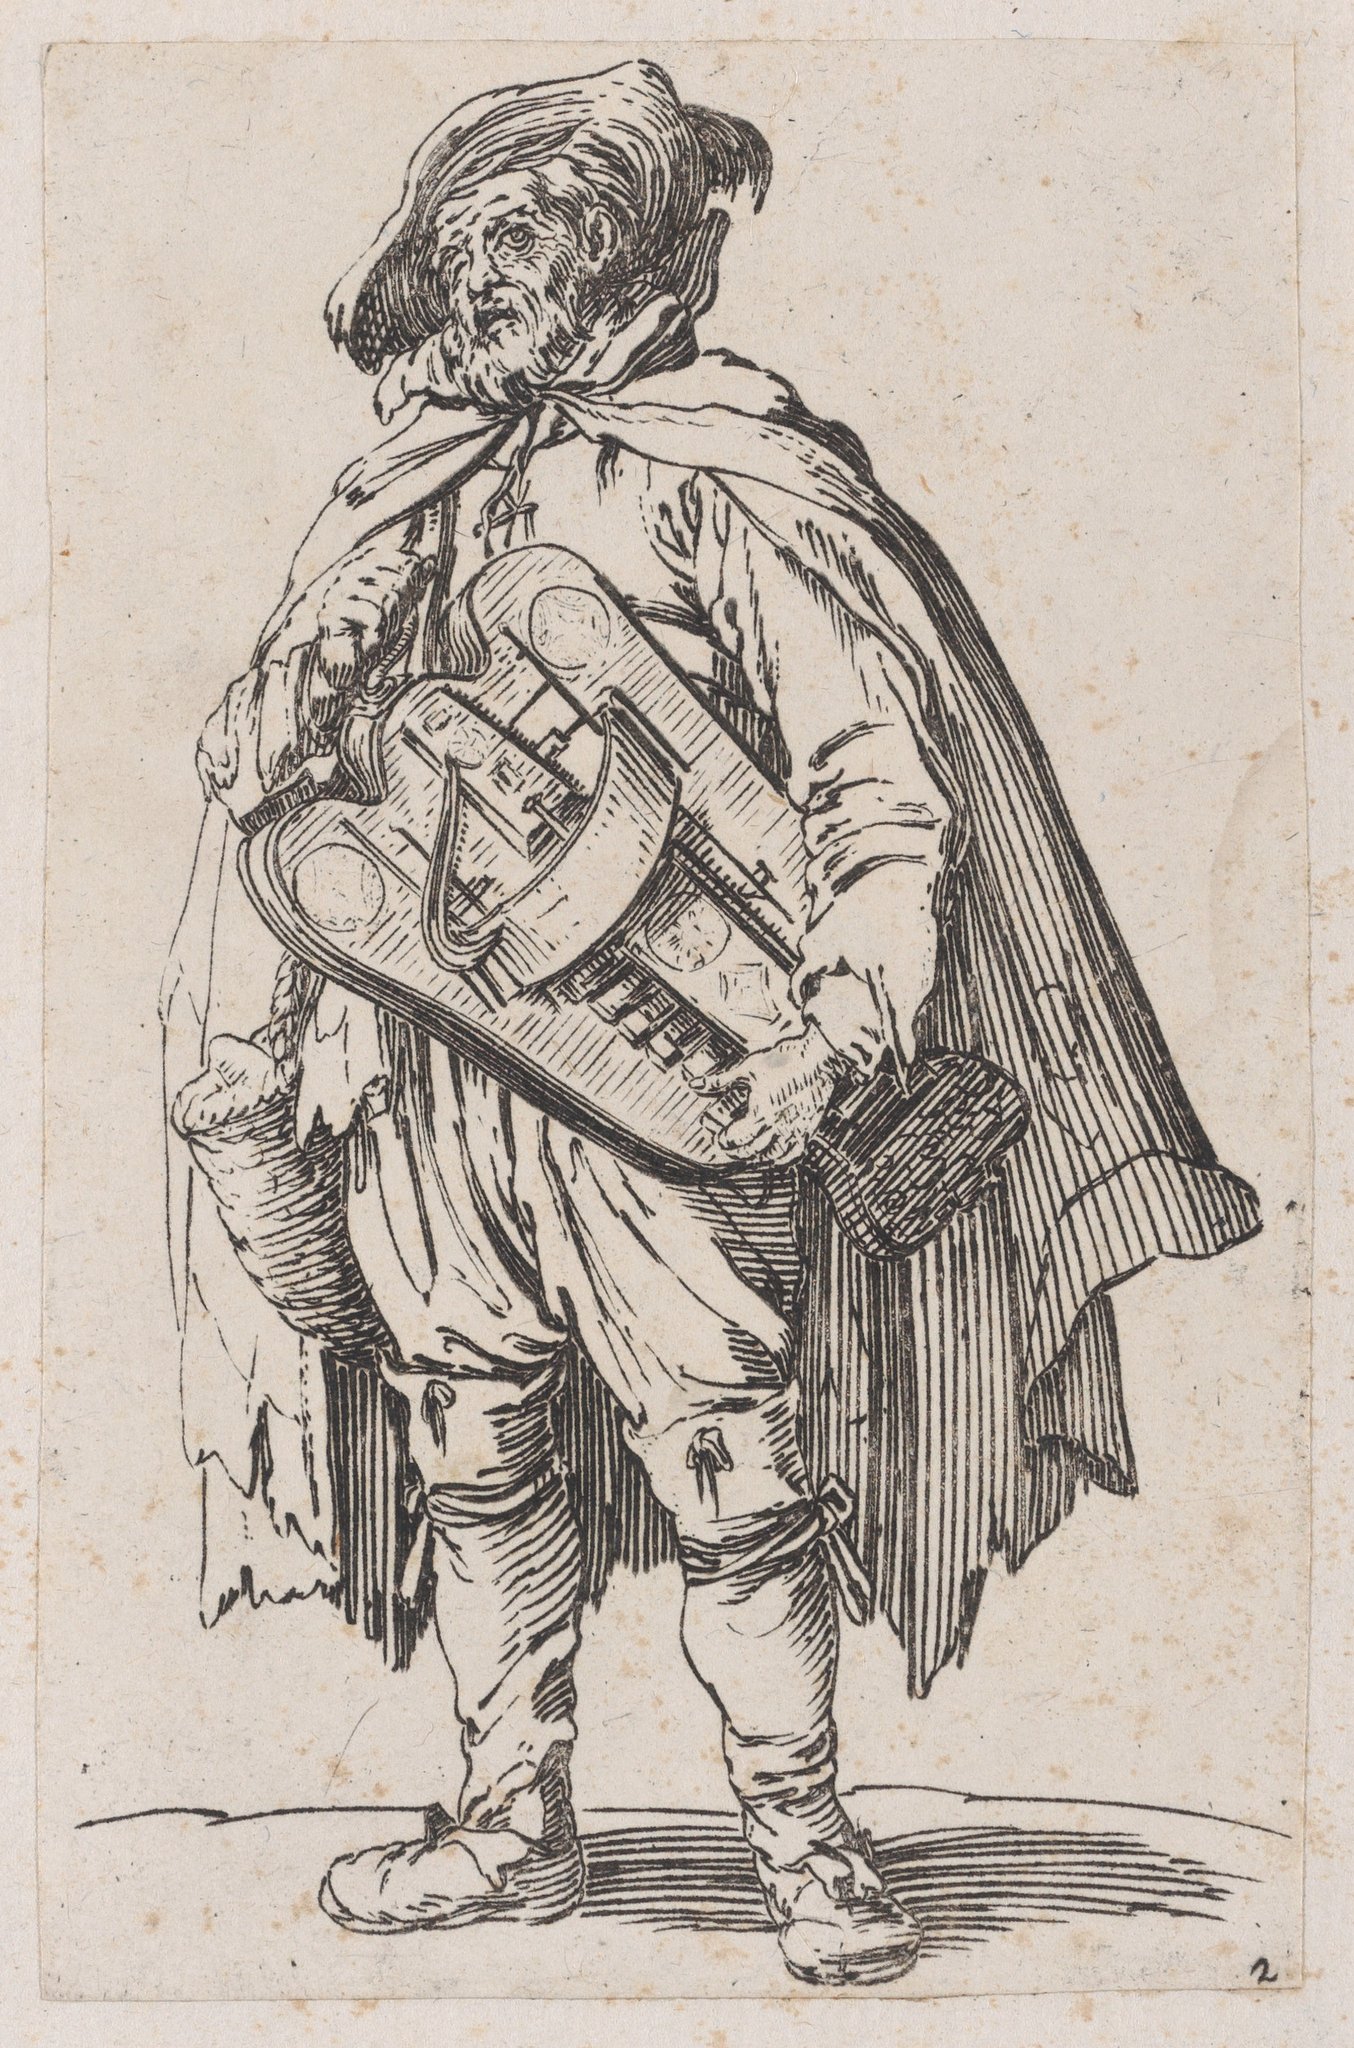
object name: print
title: Reverse Copy of Joueur de Vielle (Hurdy-Gurdy Player), from Les Gueux suite appelée aussi Les Mendiants, Les Baroni, ou Les Barons (The Beggars, also called the Barons)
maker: Anonymous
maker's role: artist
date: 1601-1700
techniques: etching